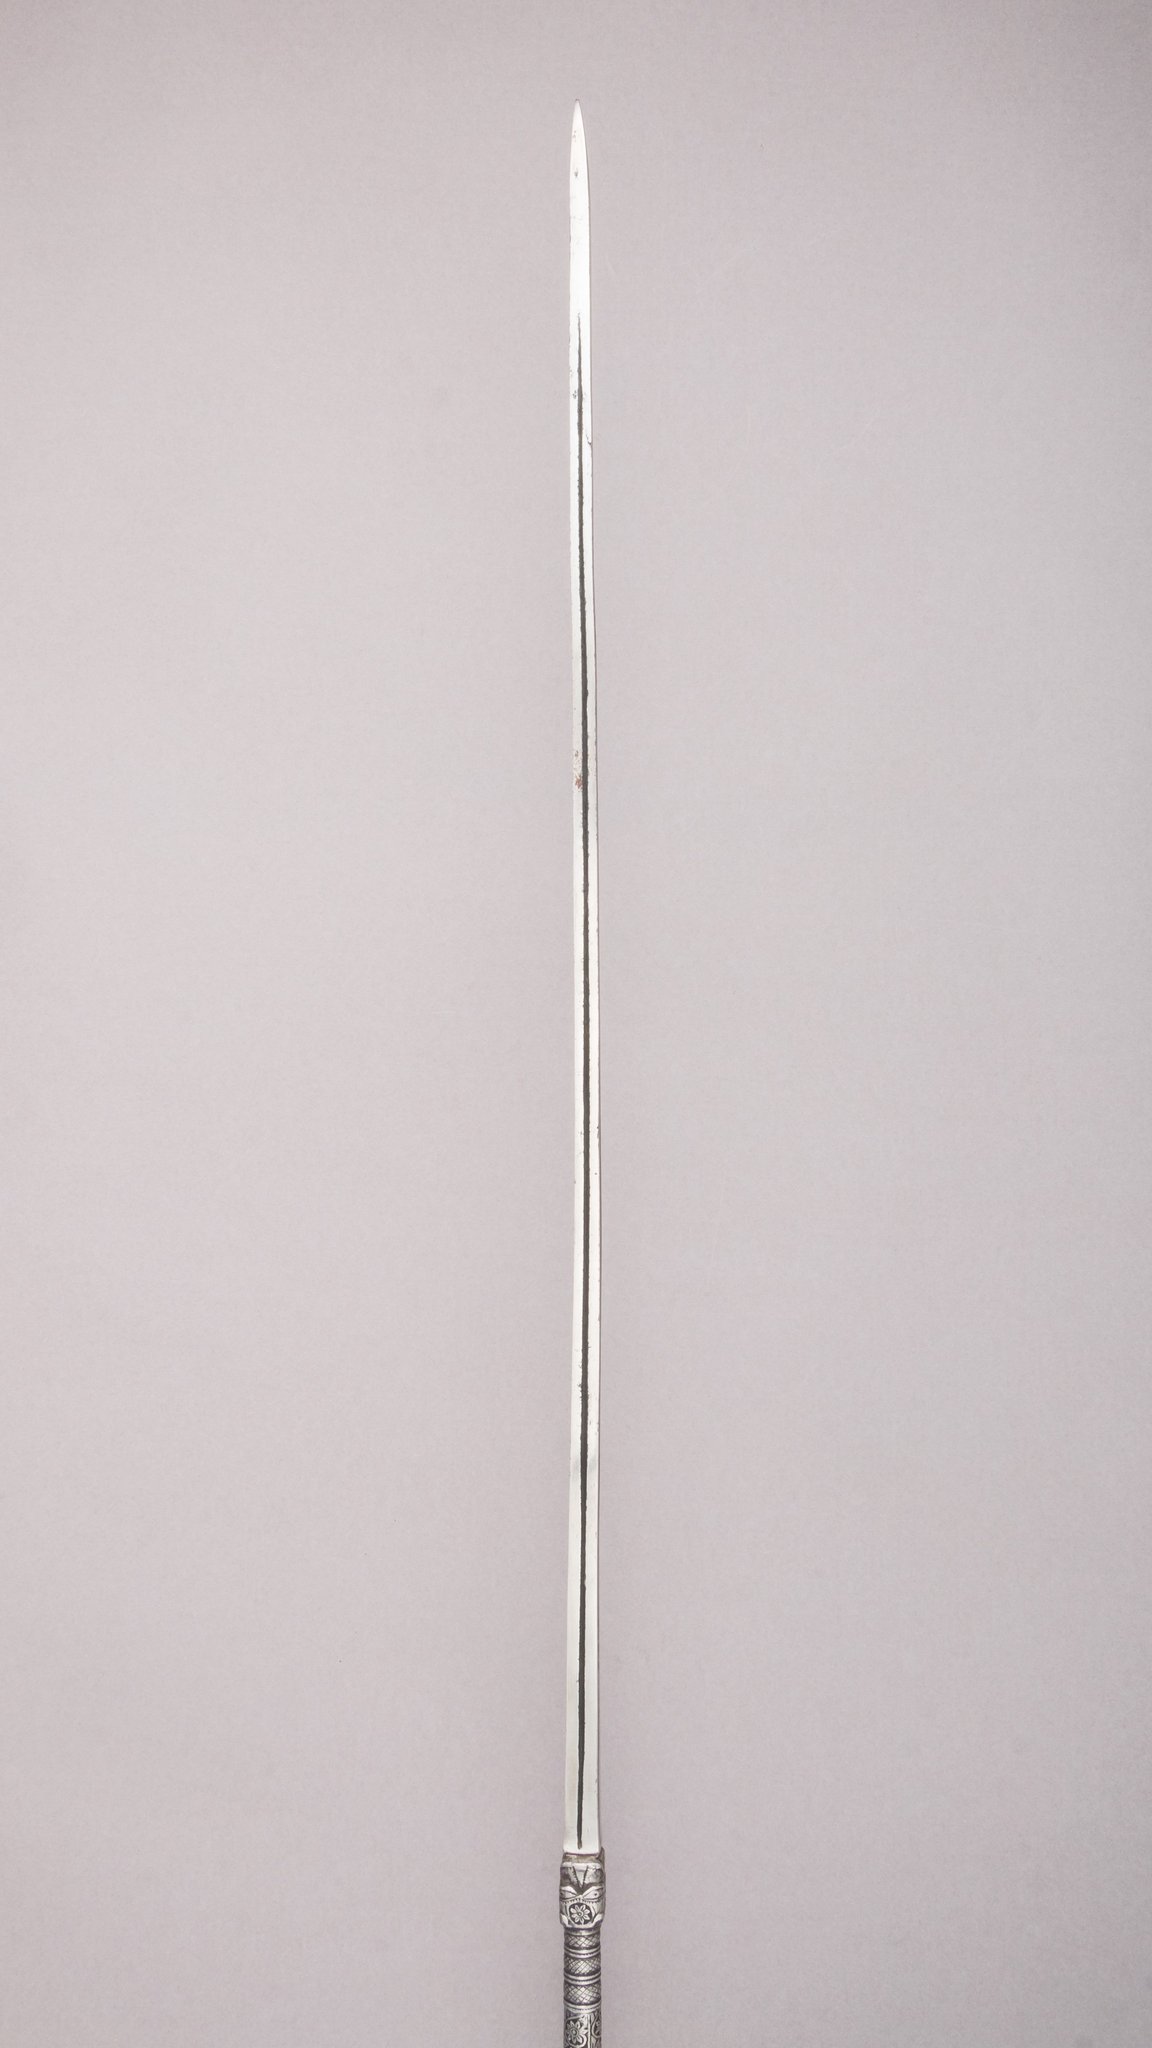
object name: spear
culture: indian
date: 1601-1700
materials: iron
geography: india